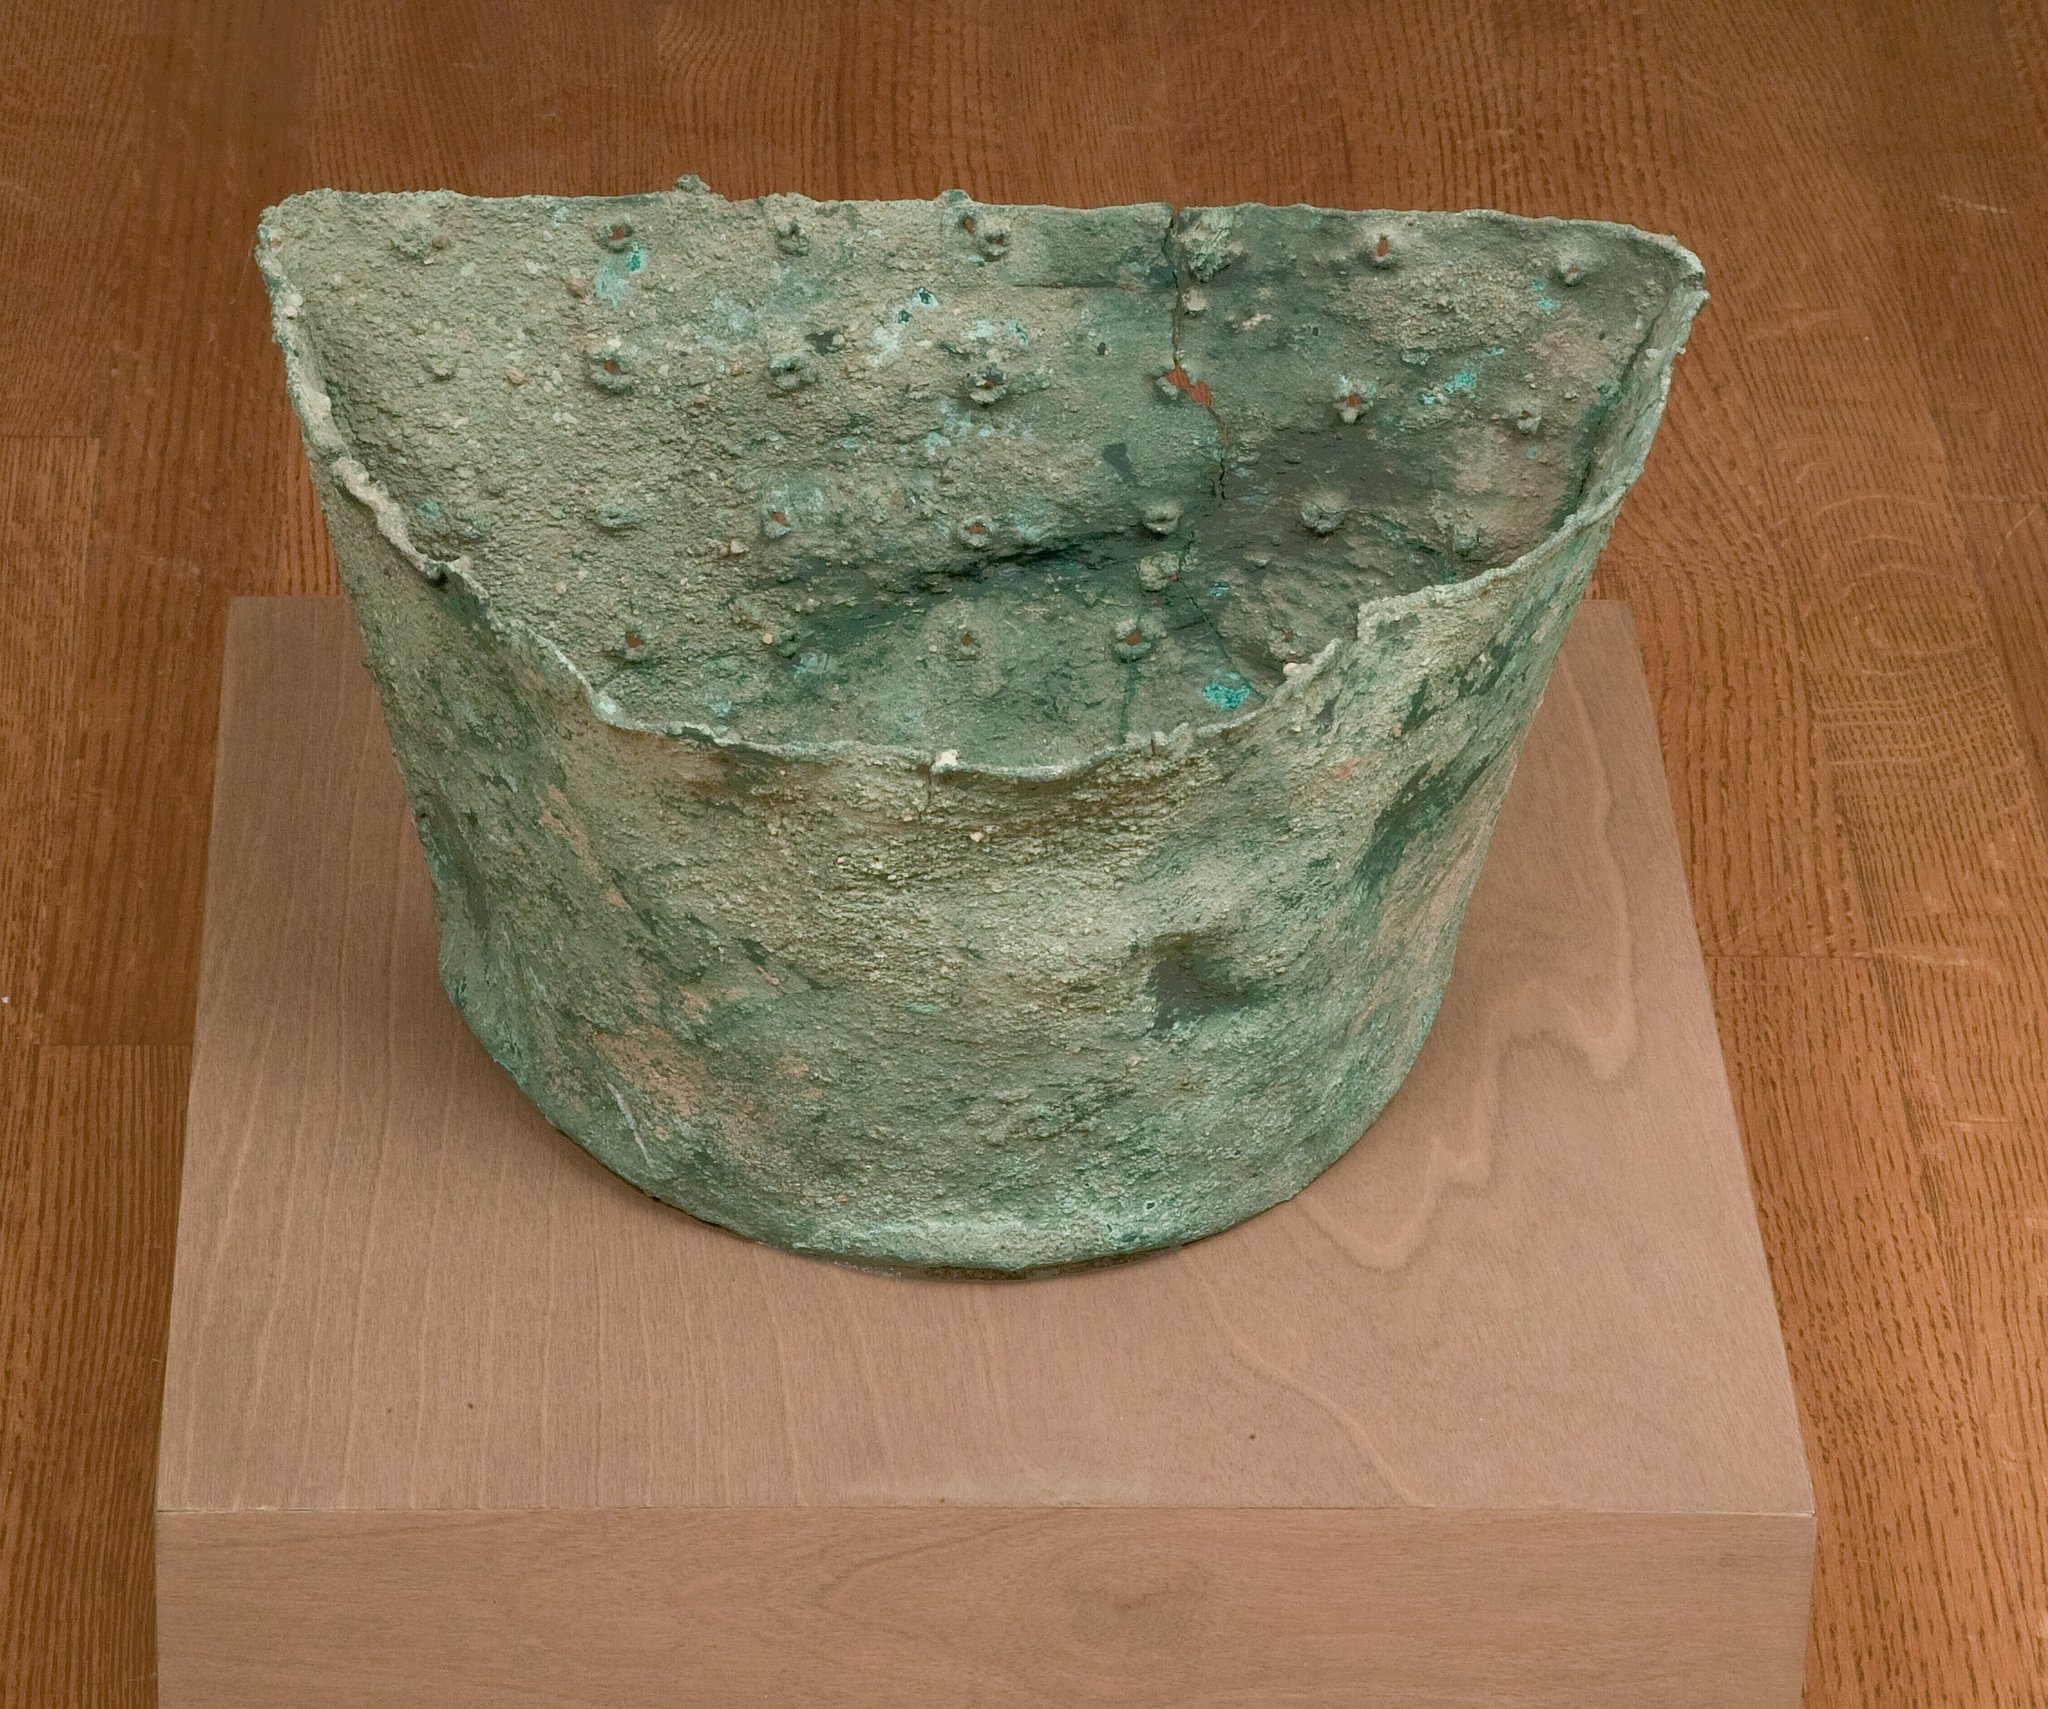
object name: vessel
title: Vessel used as a septic filter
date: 1981-1802 BCE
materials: copper alloy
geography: egypt